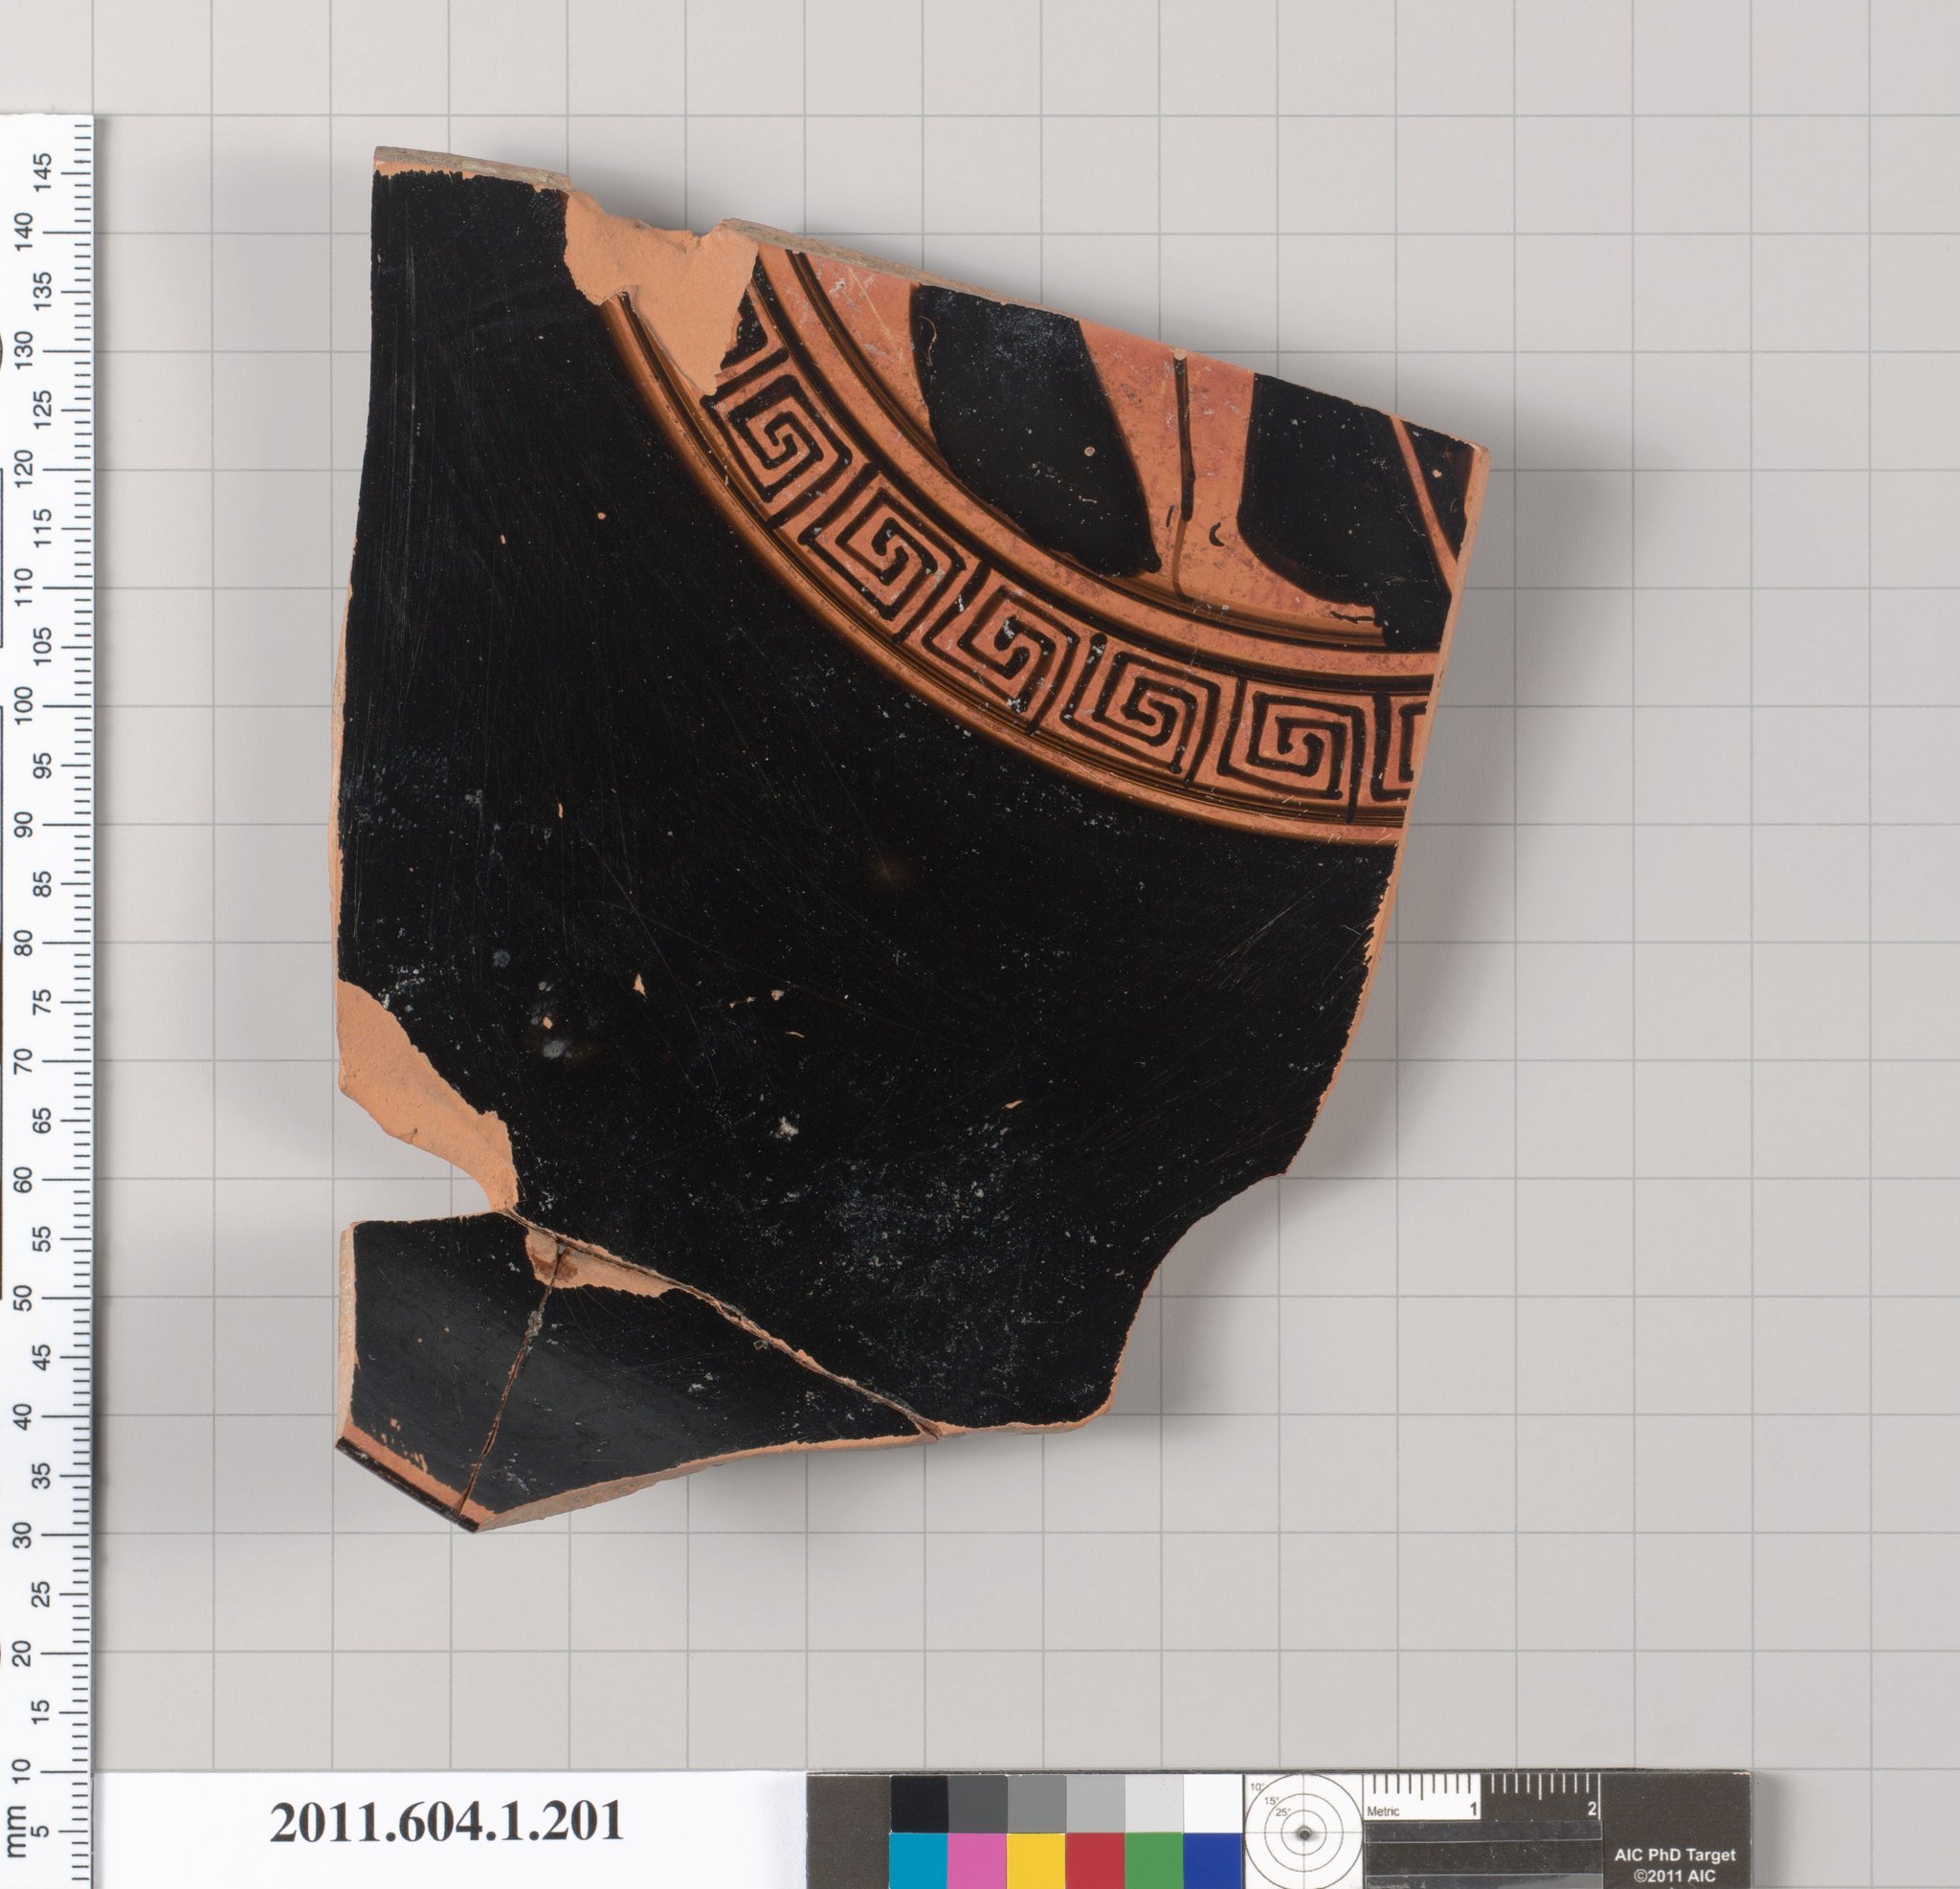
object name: kylix fragment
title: Terracotta fragment of a kylix (drinking cup)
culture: greek, attic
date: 475-451 BCE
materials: terracotta